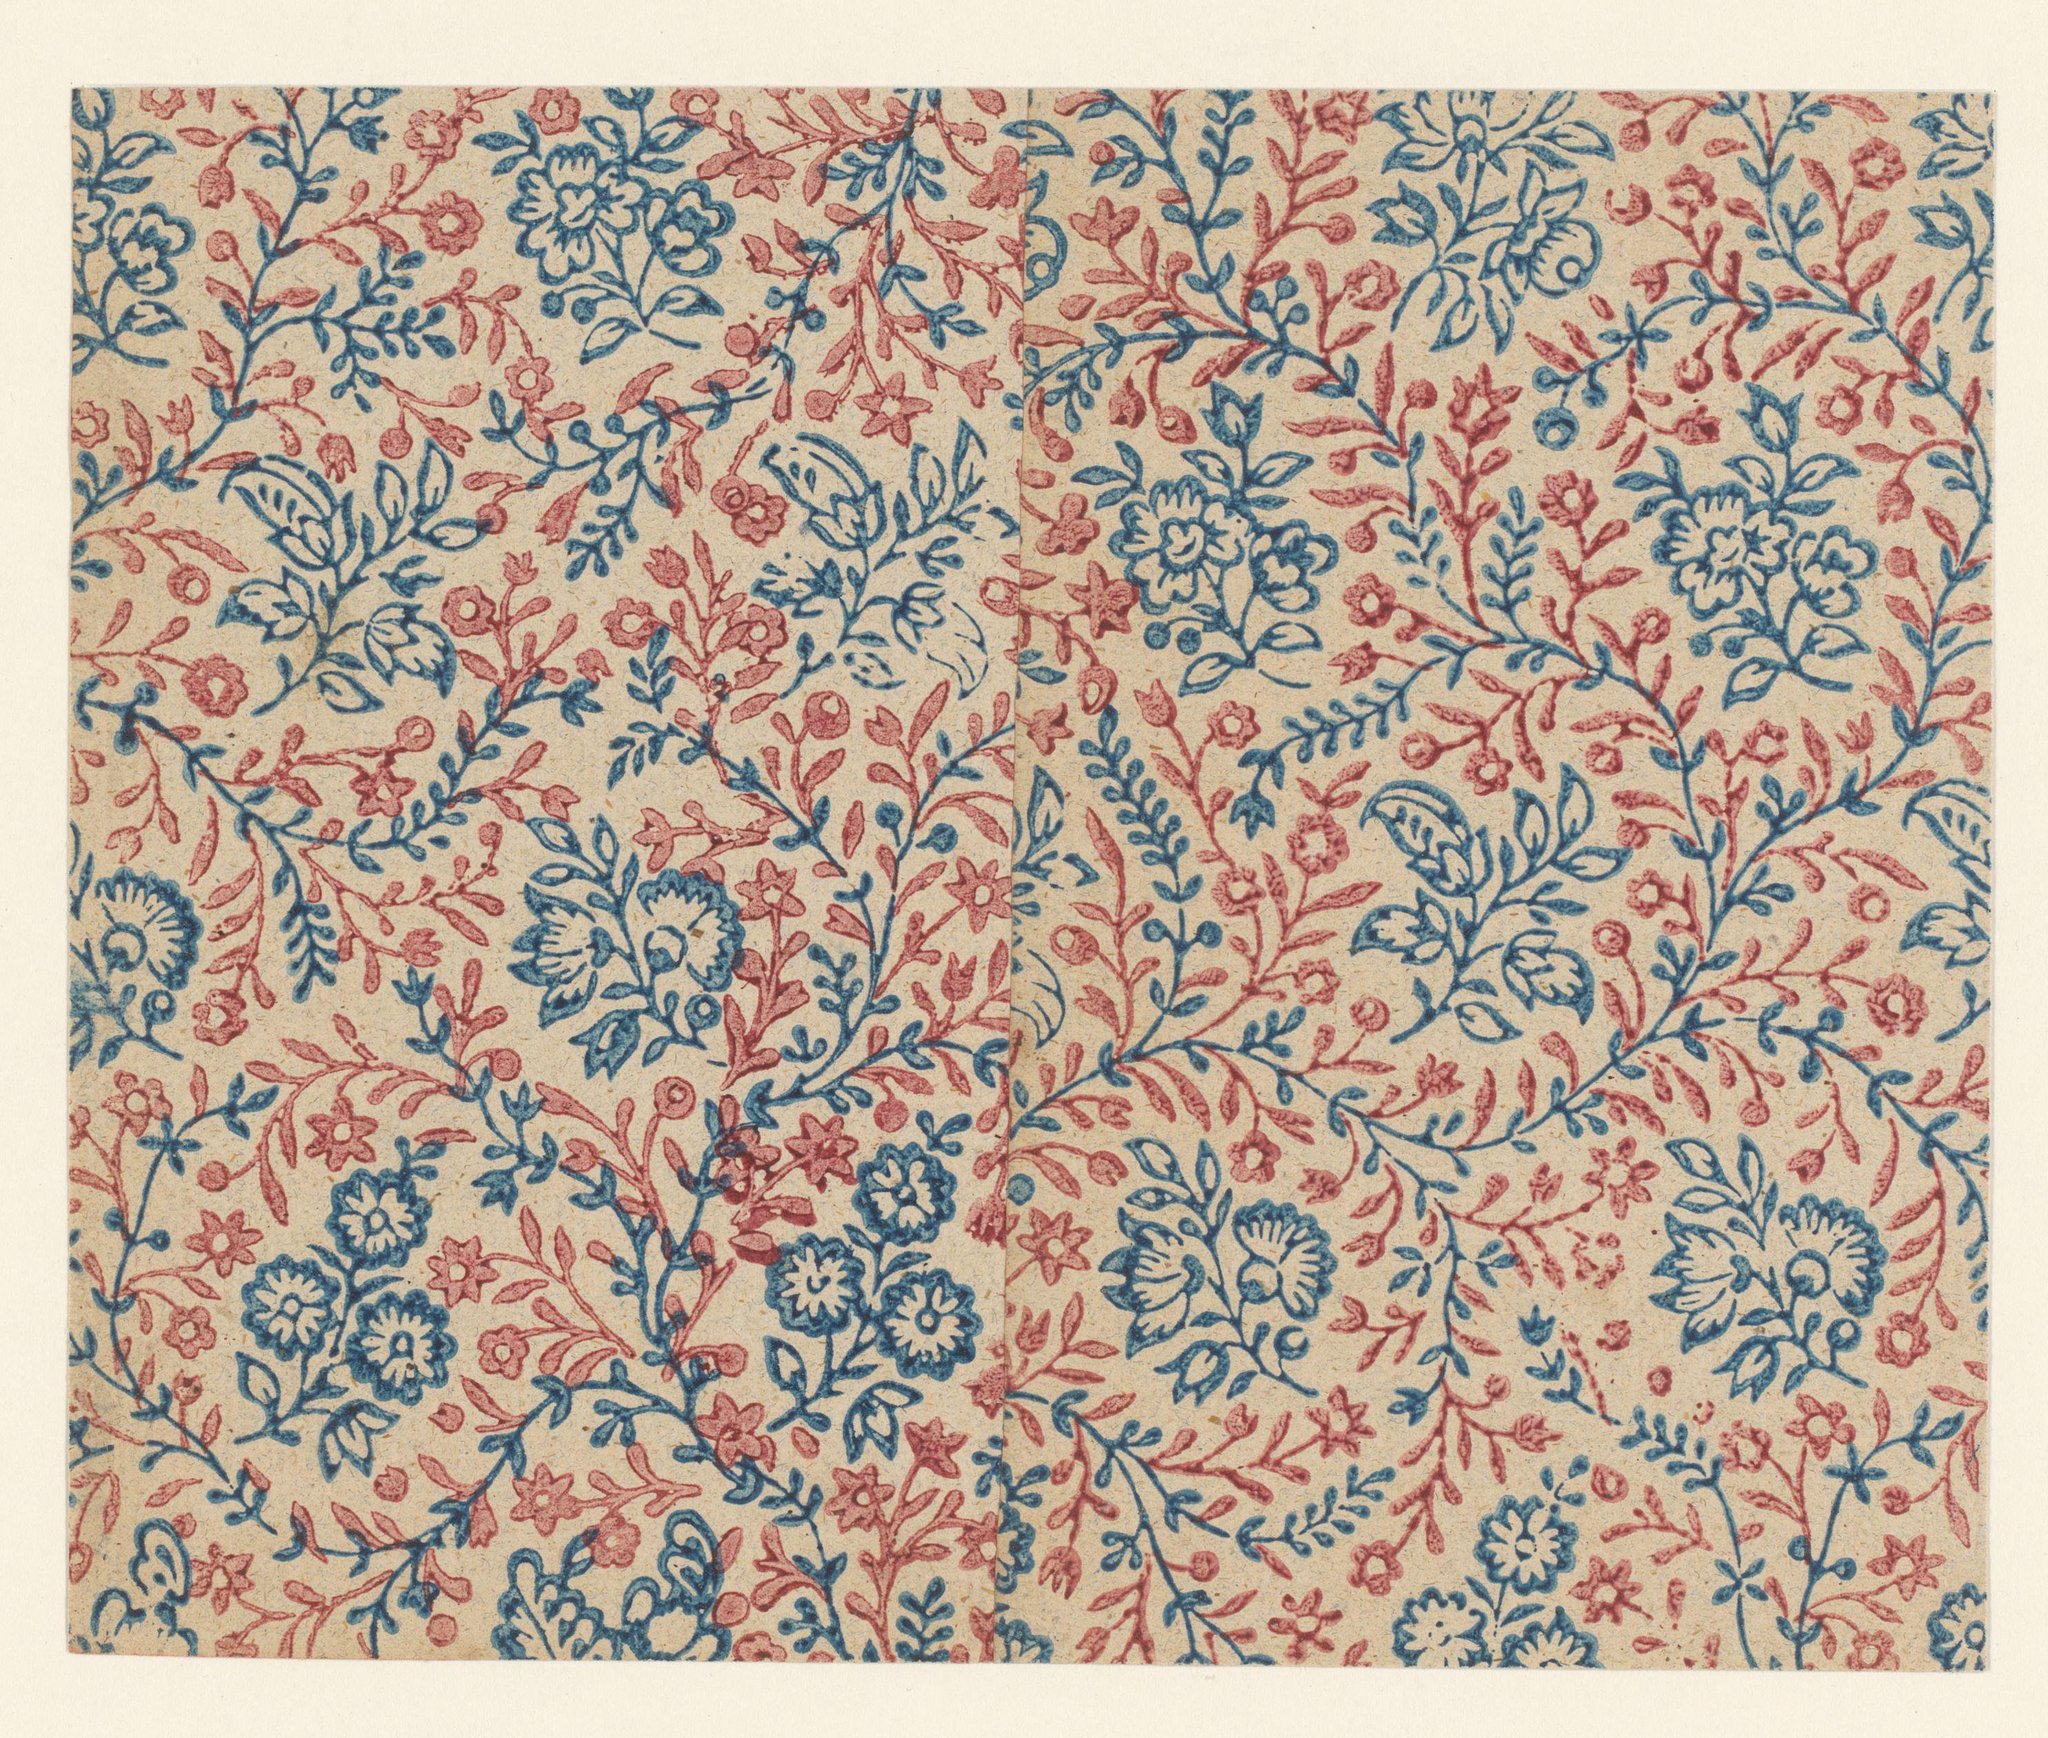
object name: printed paper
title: Blad met strooipatroon van bladranken met bloemen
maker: Anonymous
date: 1700-1850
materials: paper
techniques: printing block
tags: ornament derived from plant forms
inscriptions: annotation: ‘Lugossy 10528’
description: Blad met strooipatroon van bladranken met bloemen. Gebruikt als omslag.